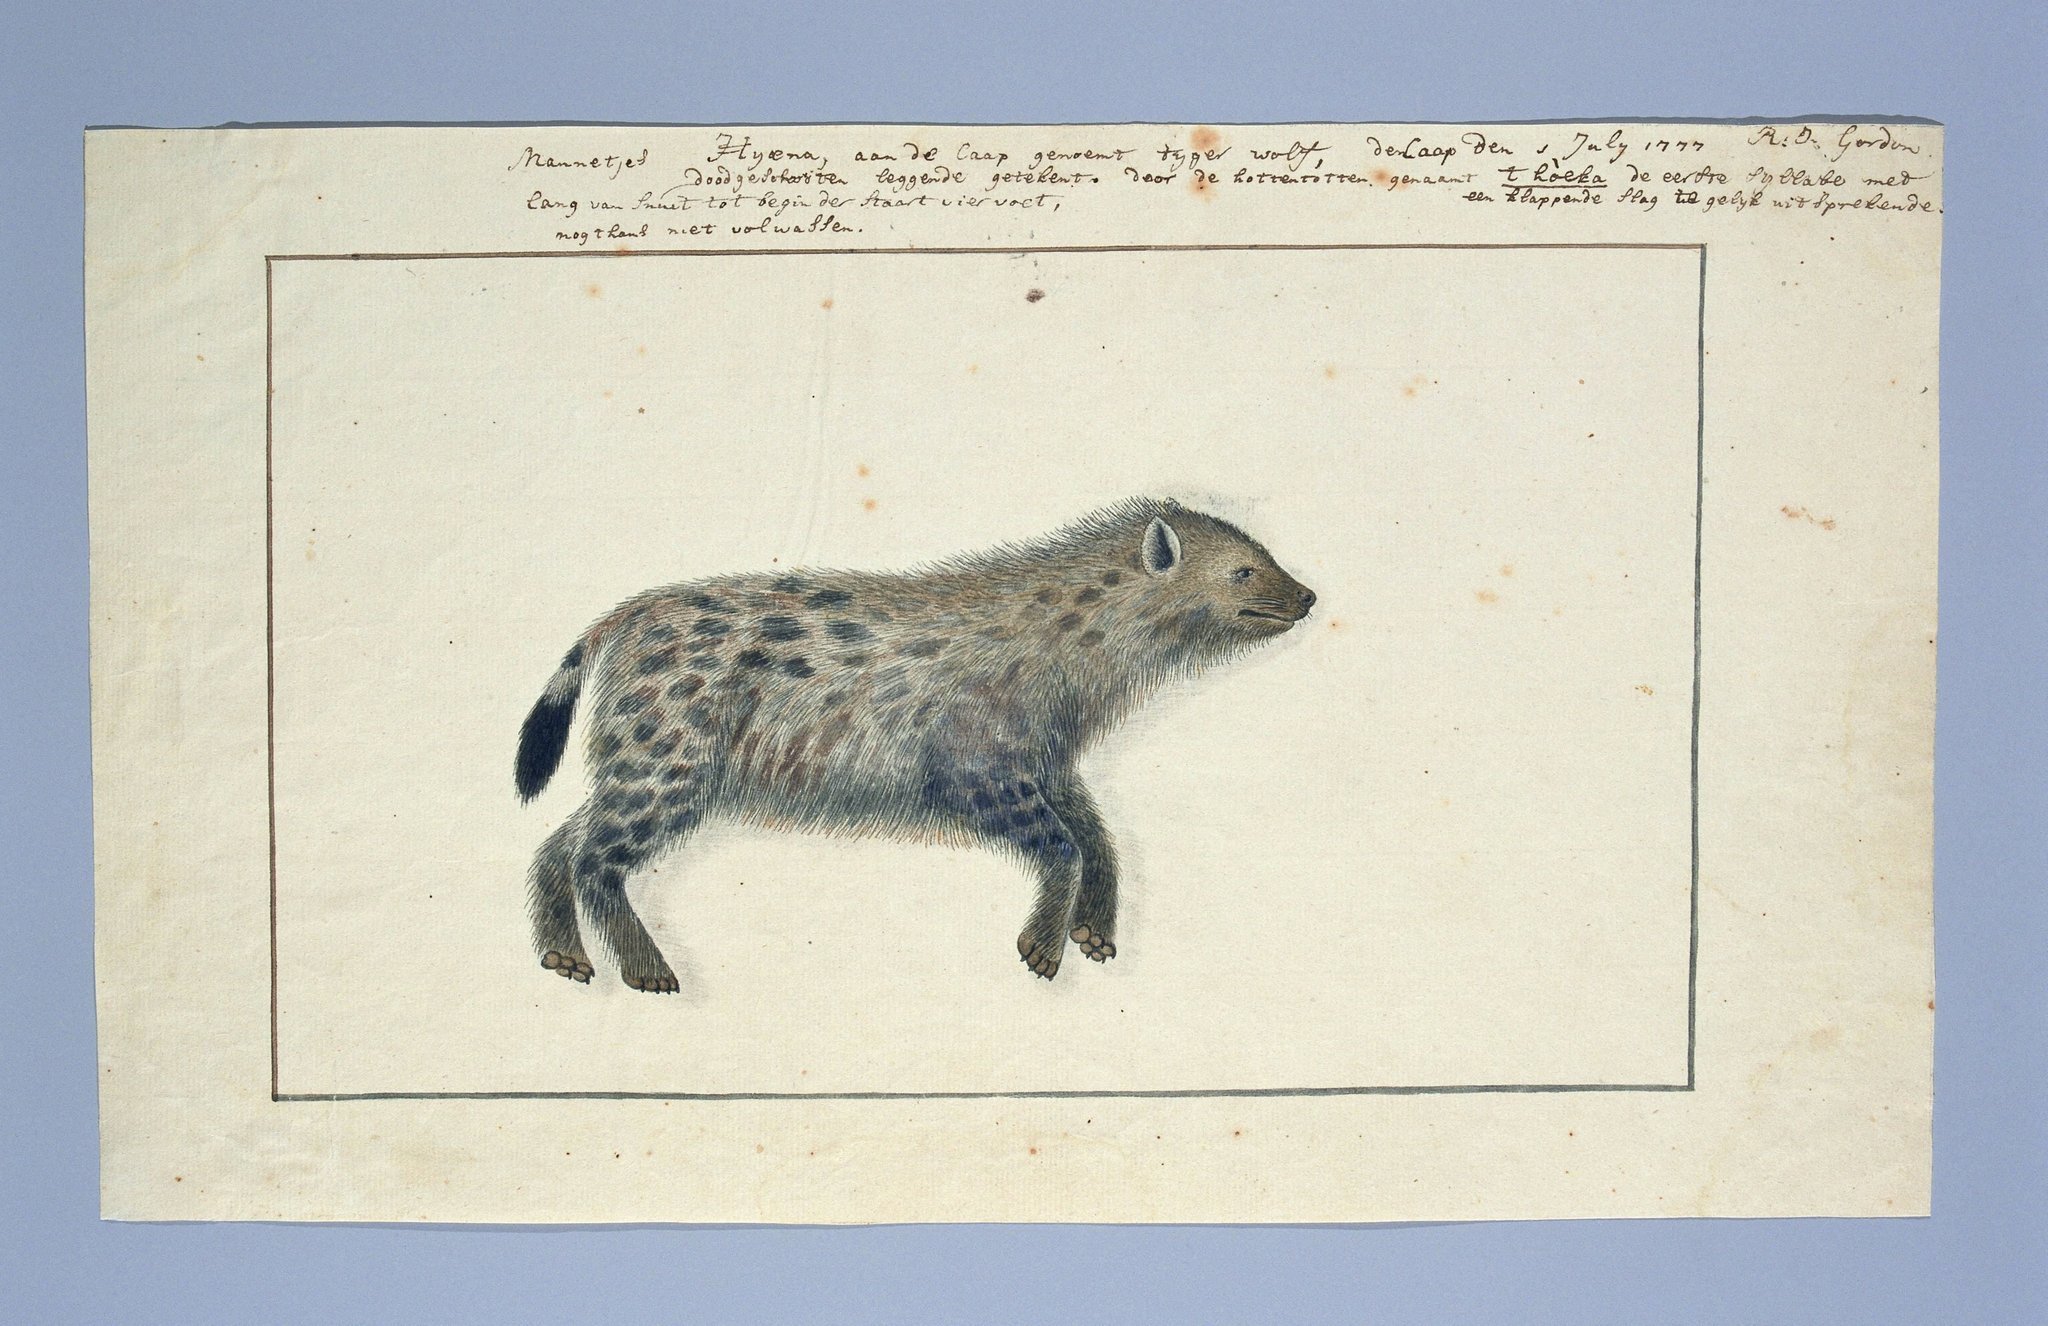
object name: dierstudie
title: Crocuta crocuta (Spotted hyena)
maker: robert jacob gordon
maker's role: draughtsman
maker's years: 1743-1795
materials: paint, ink, paper, pencil, watercolor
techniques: brush, pen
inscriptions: annotation: ‘Mannetjes Hy[a]ena, aan de Caap genoemt tyger wolf / [dan datum en signatuur] /doodgeschoo[r?]ten leggende geteekent. door hottentotten genaamt t'hòeka [onderstreept] de eerste syllabe met / [gaat rechts verder] een klappende slag te gelyk uitsprekende / links : lang van snuit tot begin der staart viervoet, / nogthans niet volwassen’, signature and date: ‘den Caap den 3 of 1(?) July 1777 R:J. Gordon’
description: Een mannetjeshyena, ook genaamd tijgerwolf, op de rechterflank gezien.